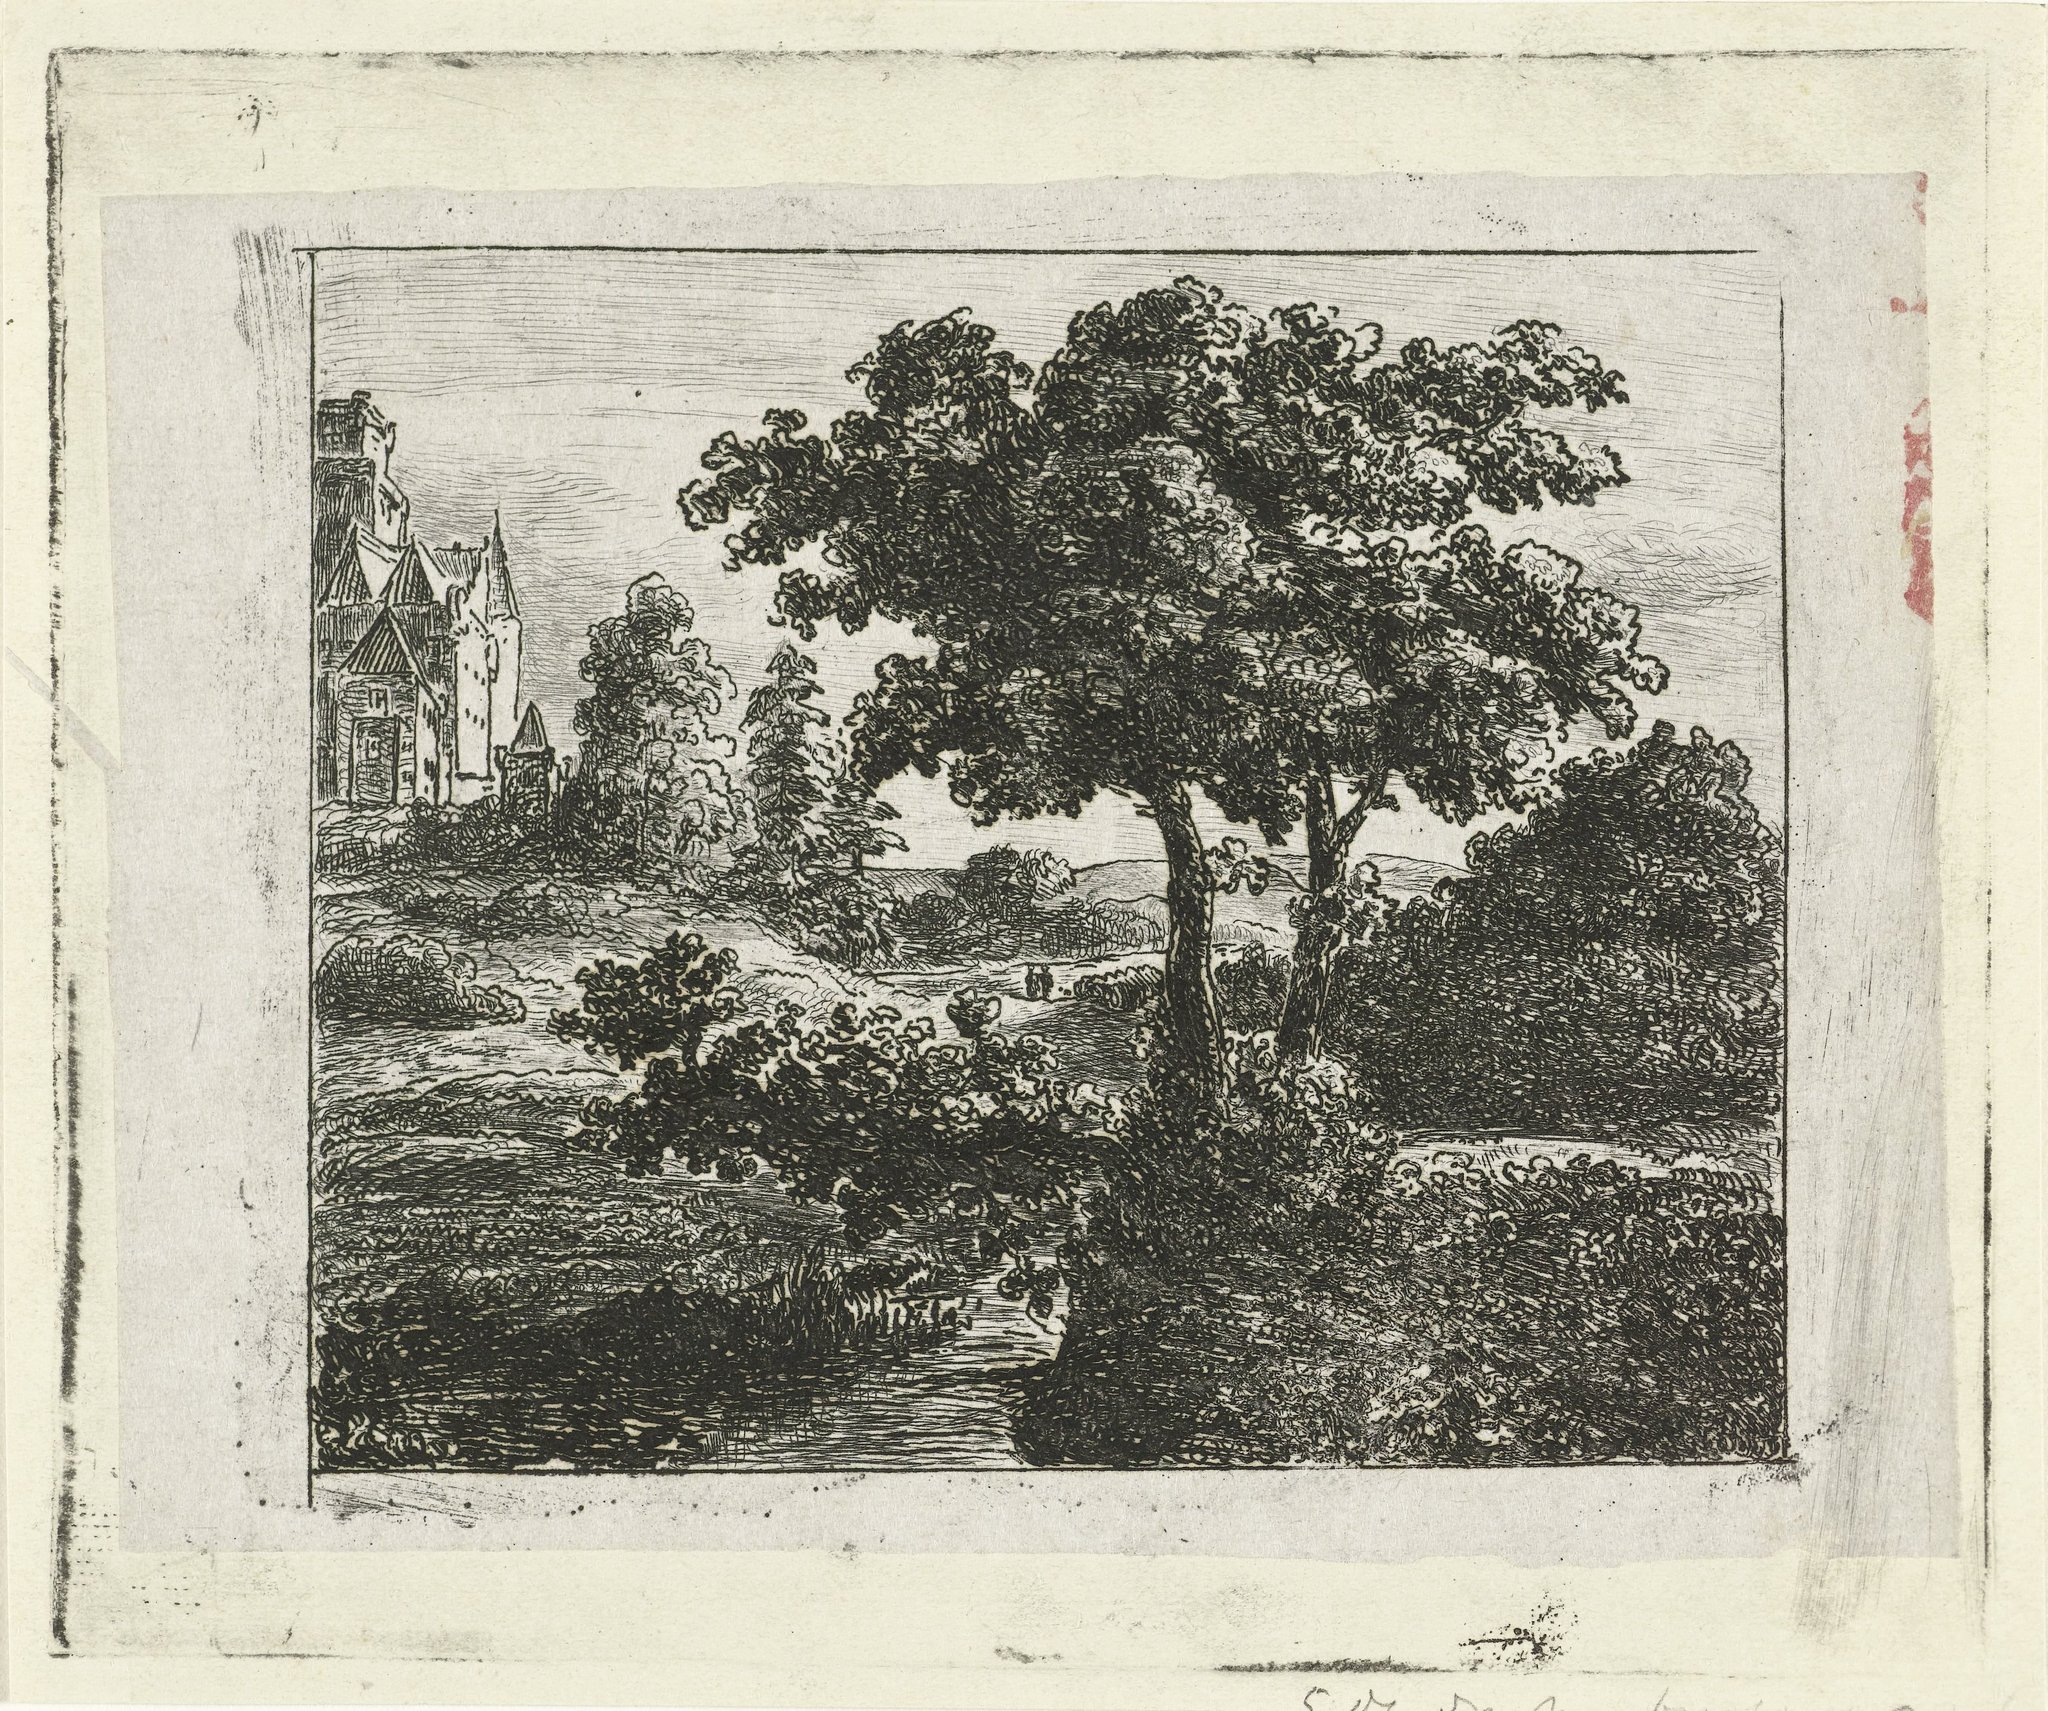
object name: print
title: Landschap met kerk op een heuvel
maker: johannes adrianus van der drift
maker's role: print maker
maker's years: 1808-1883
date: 1823-1883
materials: paper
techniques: etching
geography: netherlands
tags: landscape with other man-made constructions not mentioned above, e.g.: graveyards, playgrounds, etc.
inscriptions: collector's mark: Lugt 2228